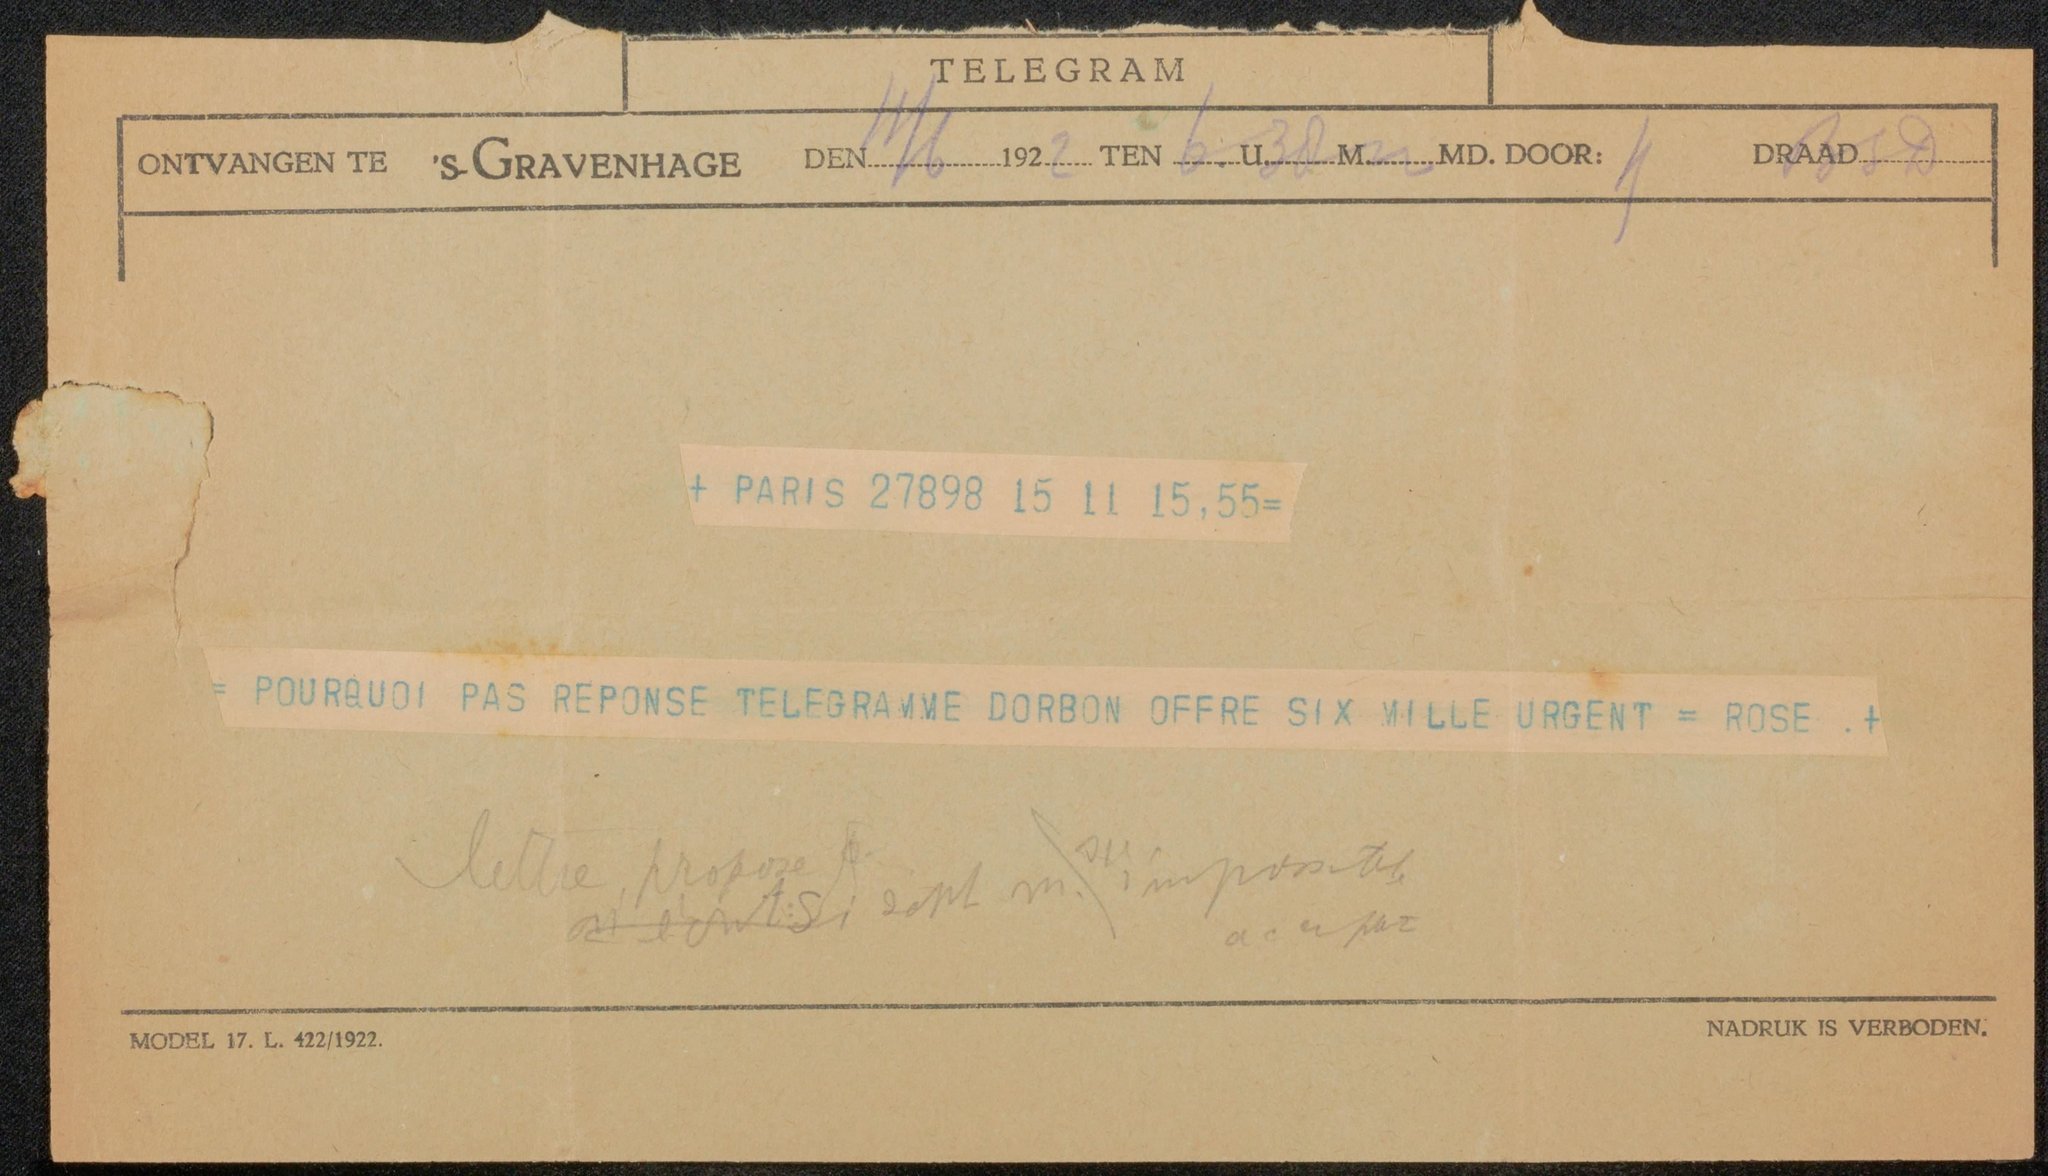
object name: telegram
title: Telegram aan Philip Zilcken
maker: rose imel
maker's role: draughtsman, painter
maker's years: 1901-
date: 1922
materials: paper, pencil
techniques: printing, typewriting, writing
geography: paris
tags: paris, publisher, the hague, draughtsman, philip zilcken, money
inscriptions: collector's mark: ‘RPK’